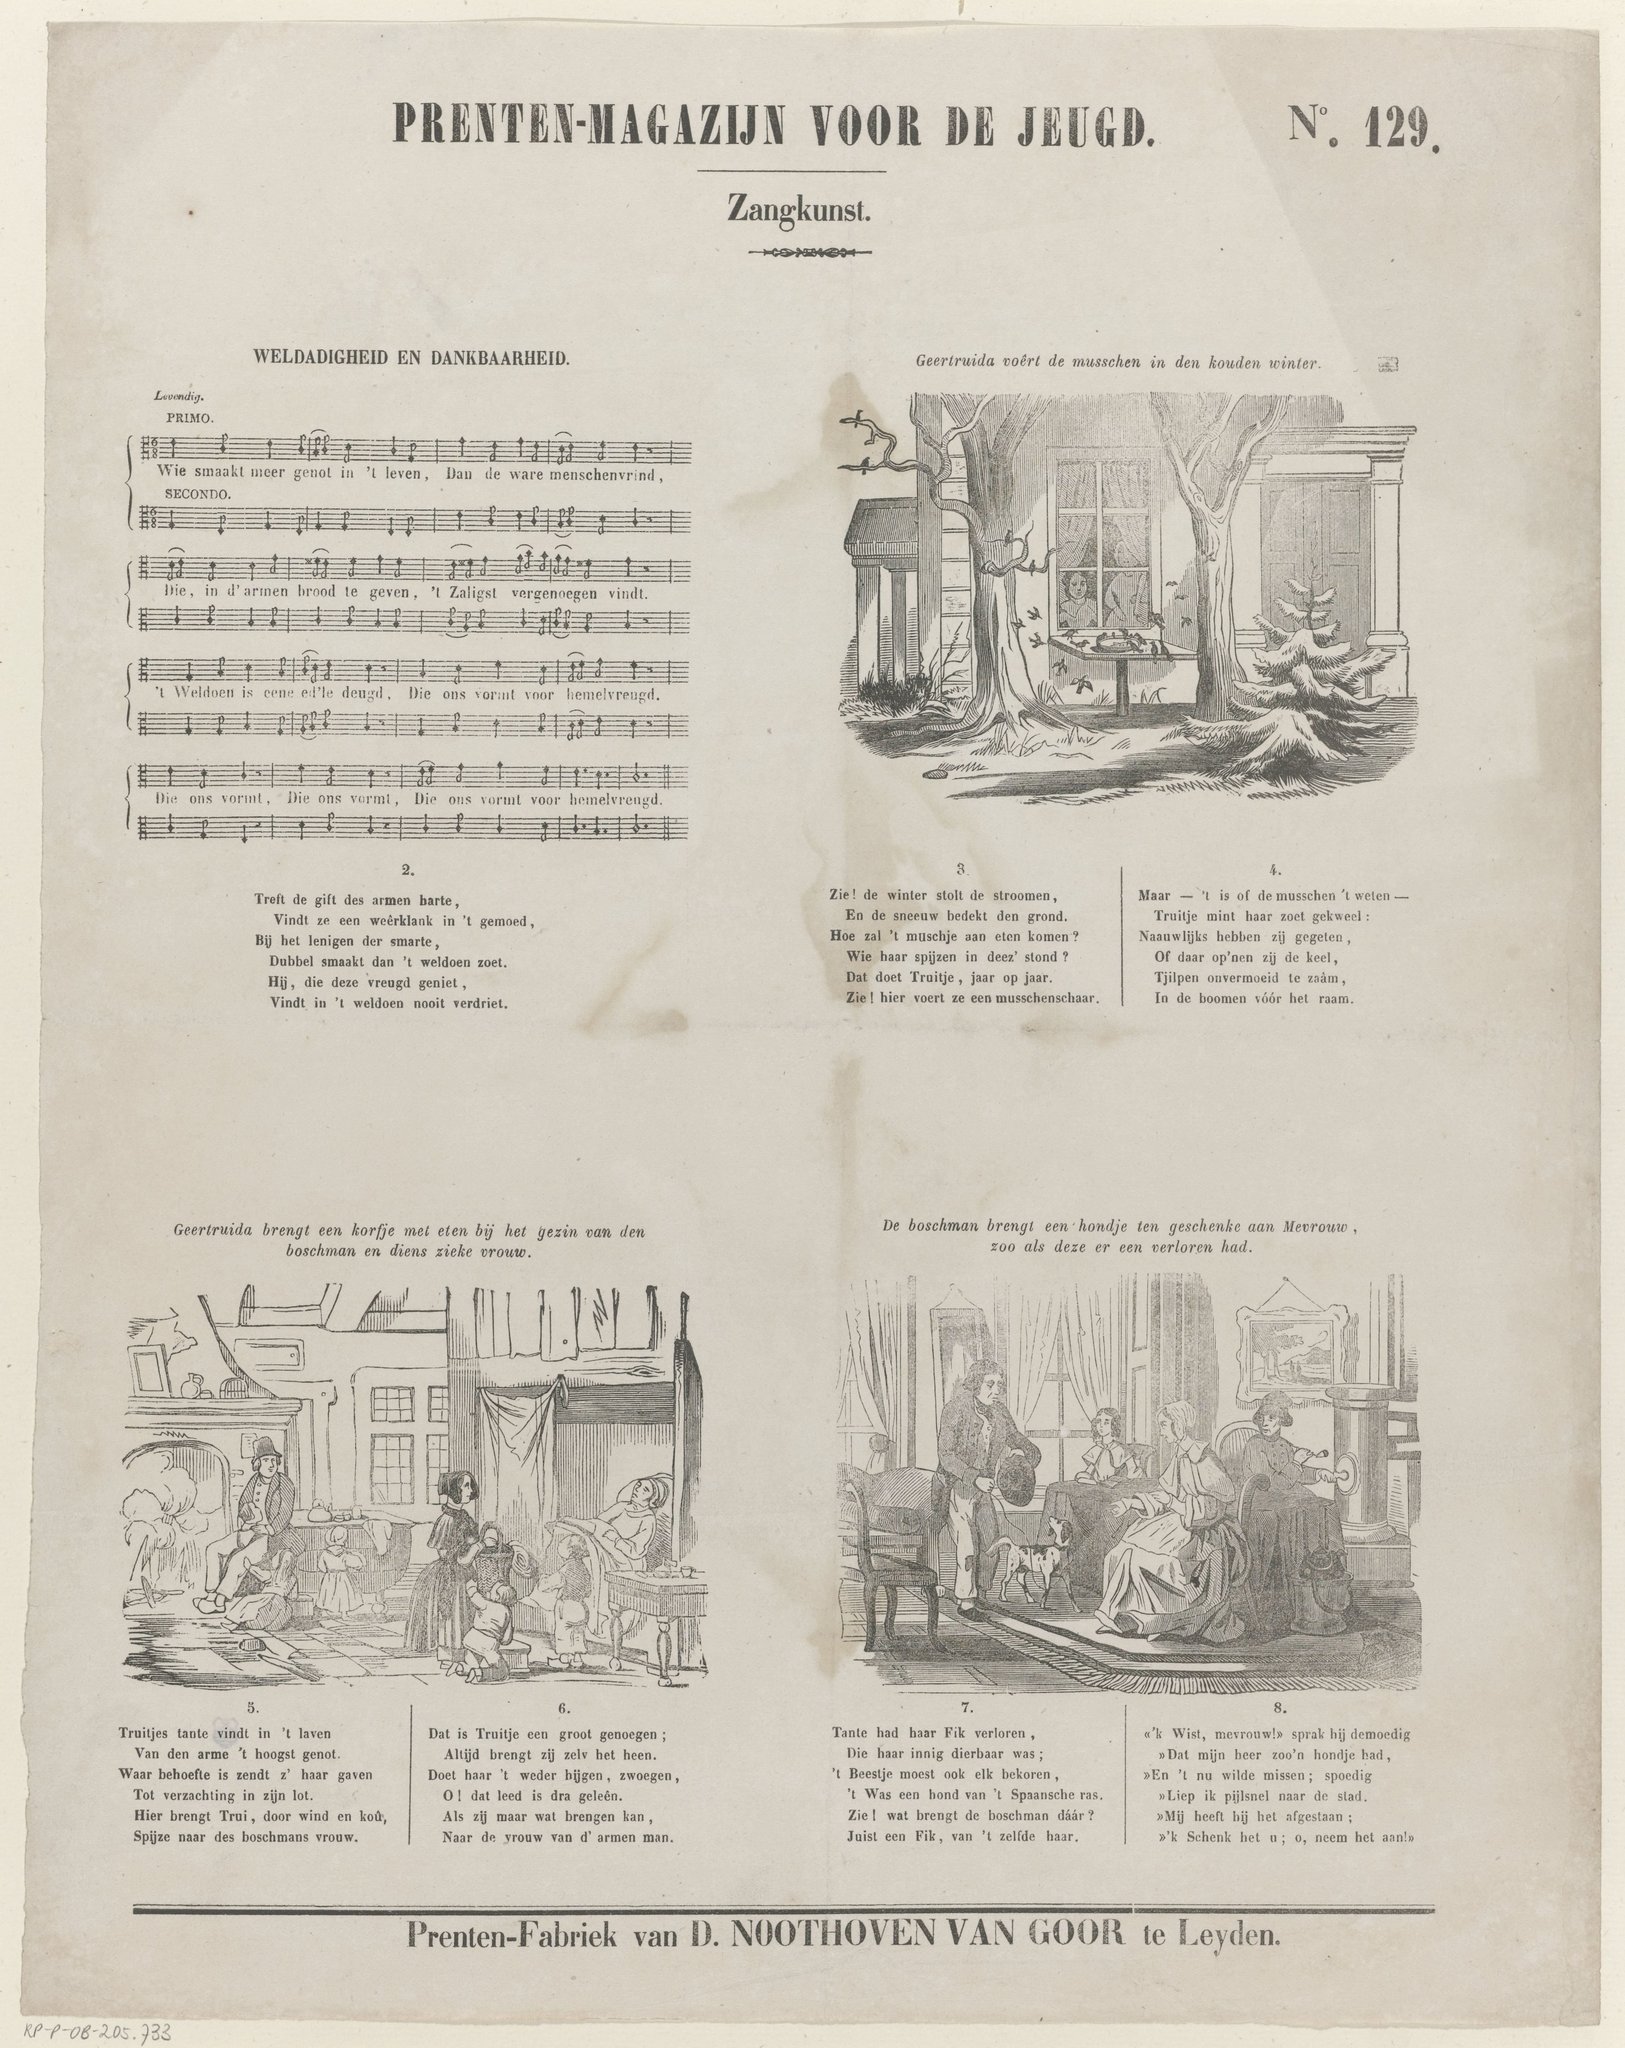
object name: popular print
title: Weldadigheid en dankbaarheid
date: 1850-1881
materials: paper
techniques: letterpress printing, engraving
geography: netherlands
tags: benevolence, beneficence; 'beneficio', 'benevolenza o affettione' (ripa), gratitude; 'gratitudine', 'memoria grata de beneficii ricevuti' (ripa)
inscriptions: collector's mark: Lugt 2760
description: Blad met 3 voorstellingen en een stuk bladmuziek met een lied over weldadigheid en dankbaarheid. Boven elke voorstelling een titel en onder elke voorstelling coupletten van het lied. Genummerd rechtsboven: No. 129.